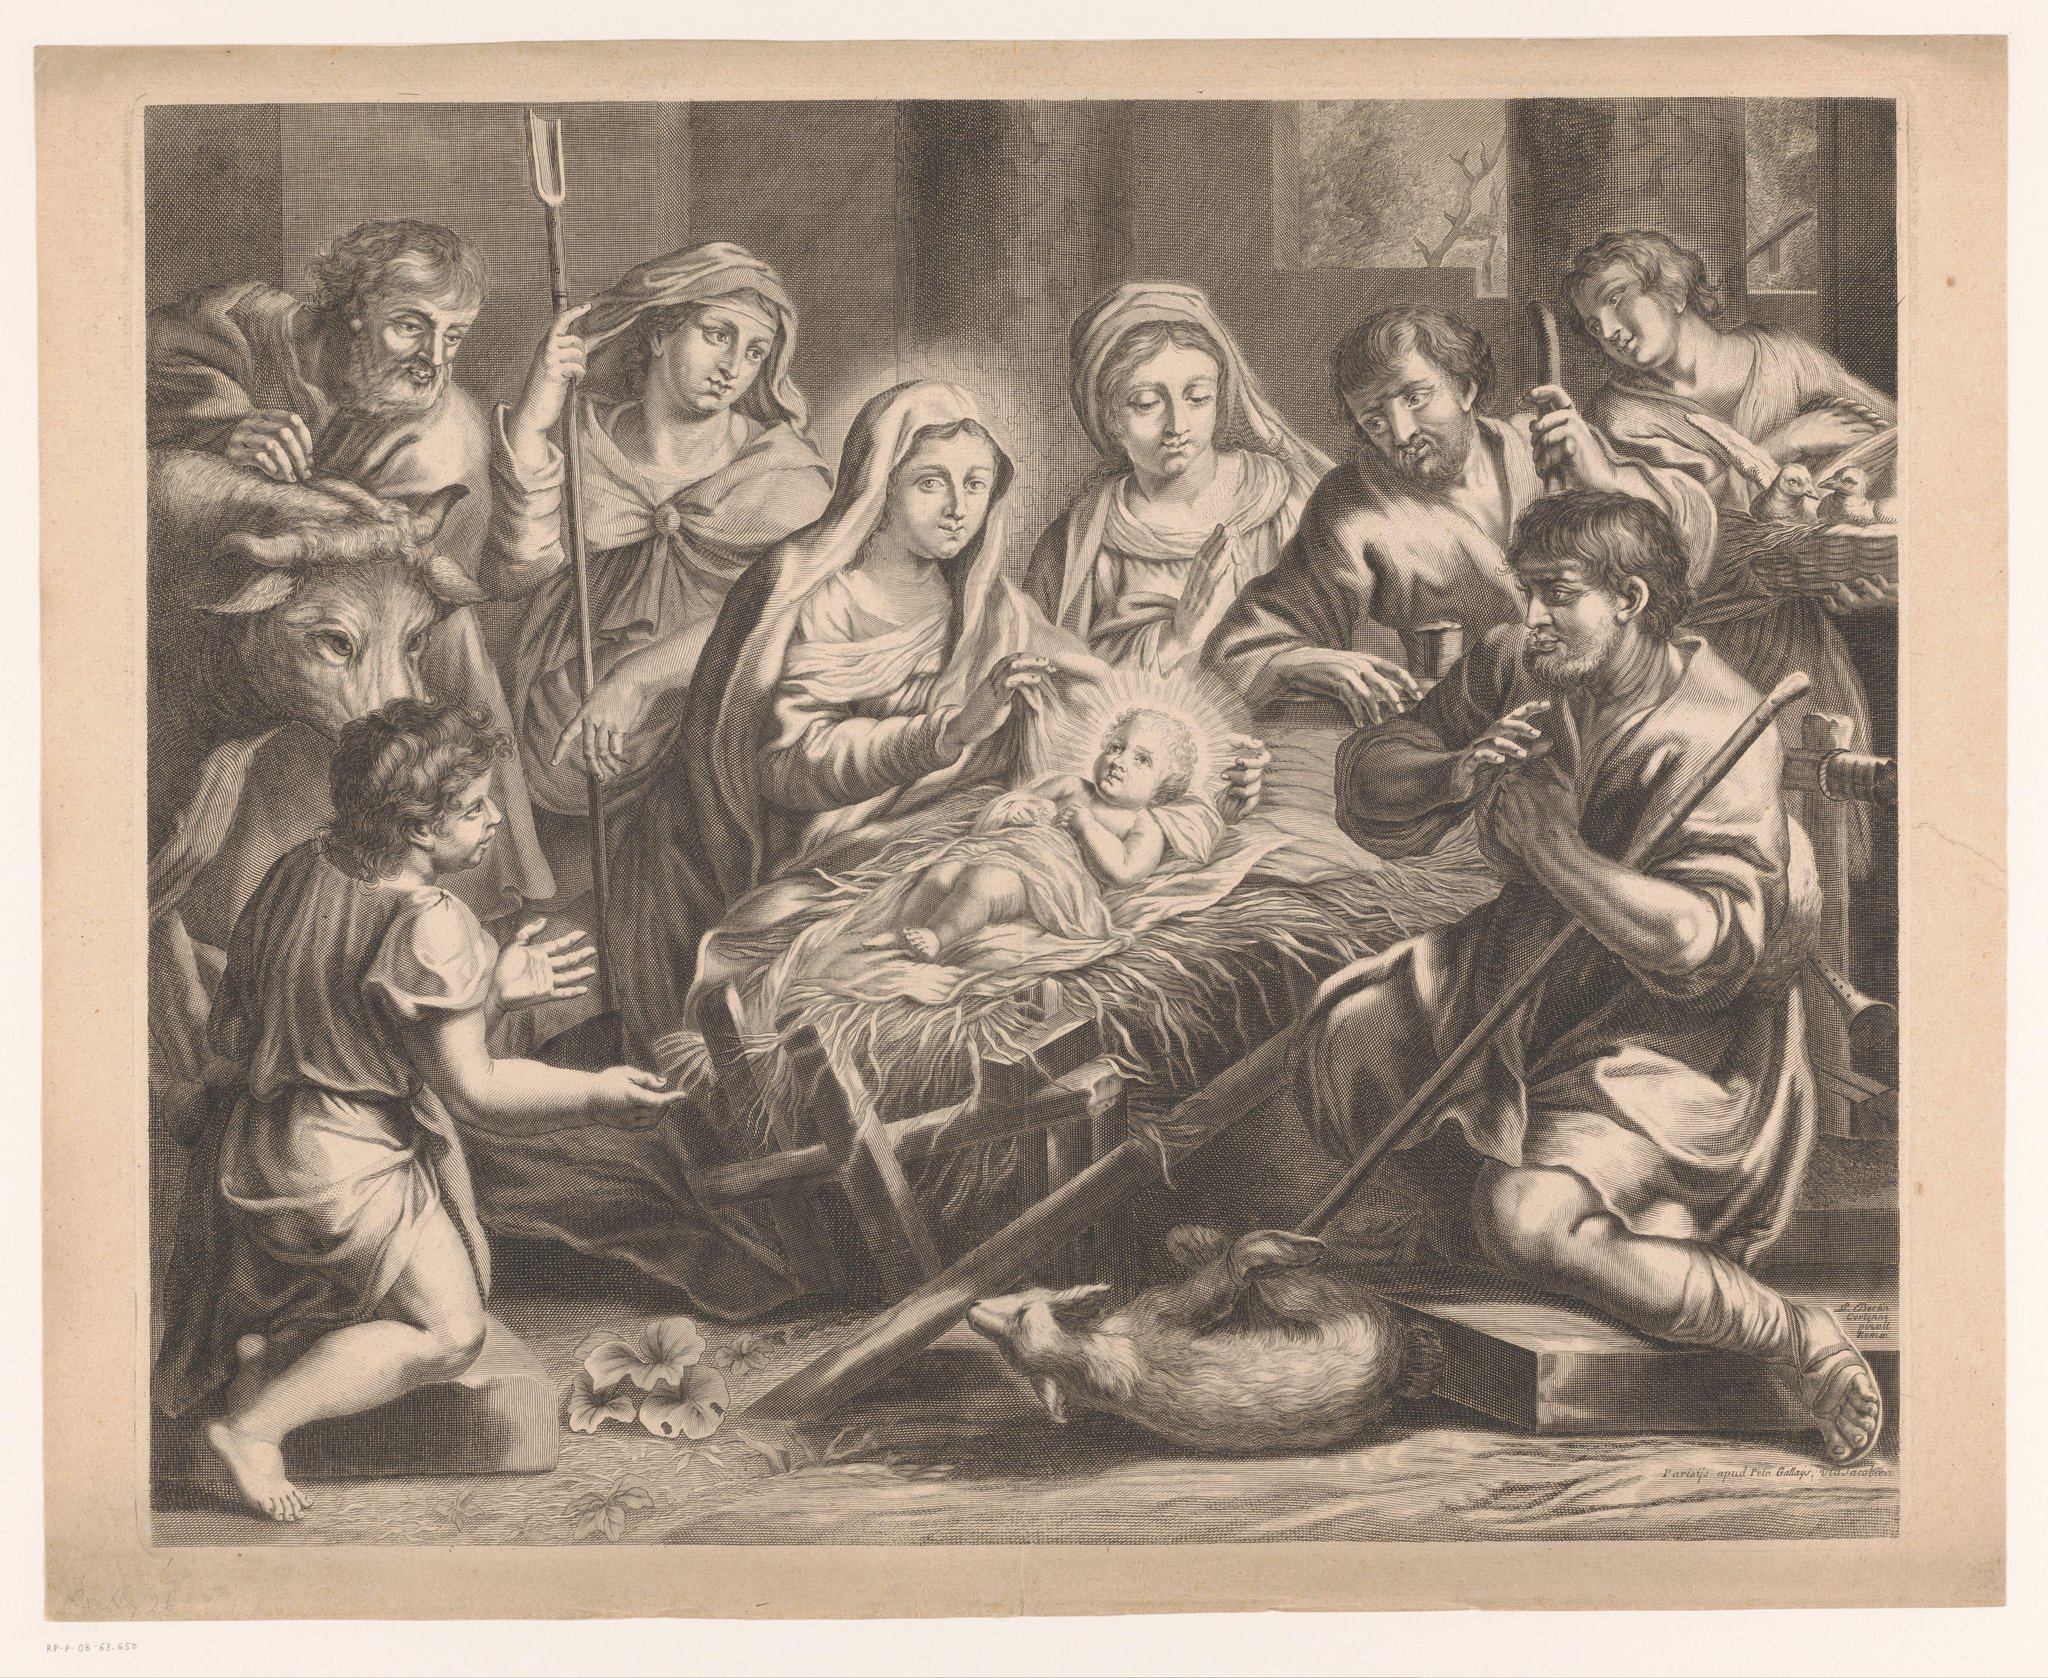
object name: print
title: Aanbidding van de herders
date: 1687-1749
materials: paper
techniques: engraving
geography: paris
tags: adoration of the christ-child by the shepherds; mary and joseph present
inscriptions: collector's mark: Lugt 240